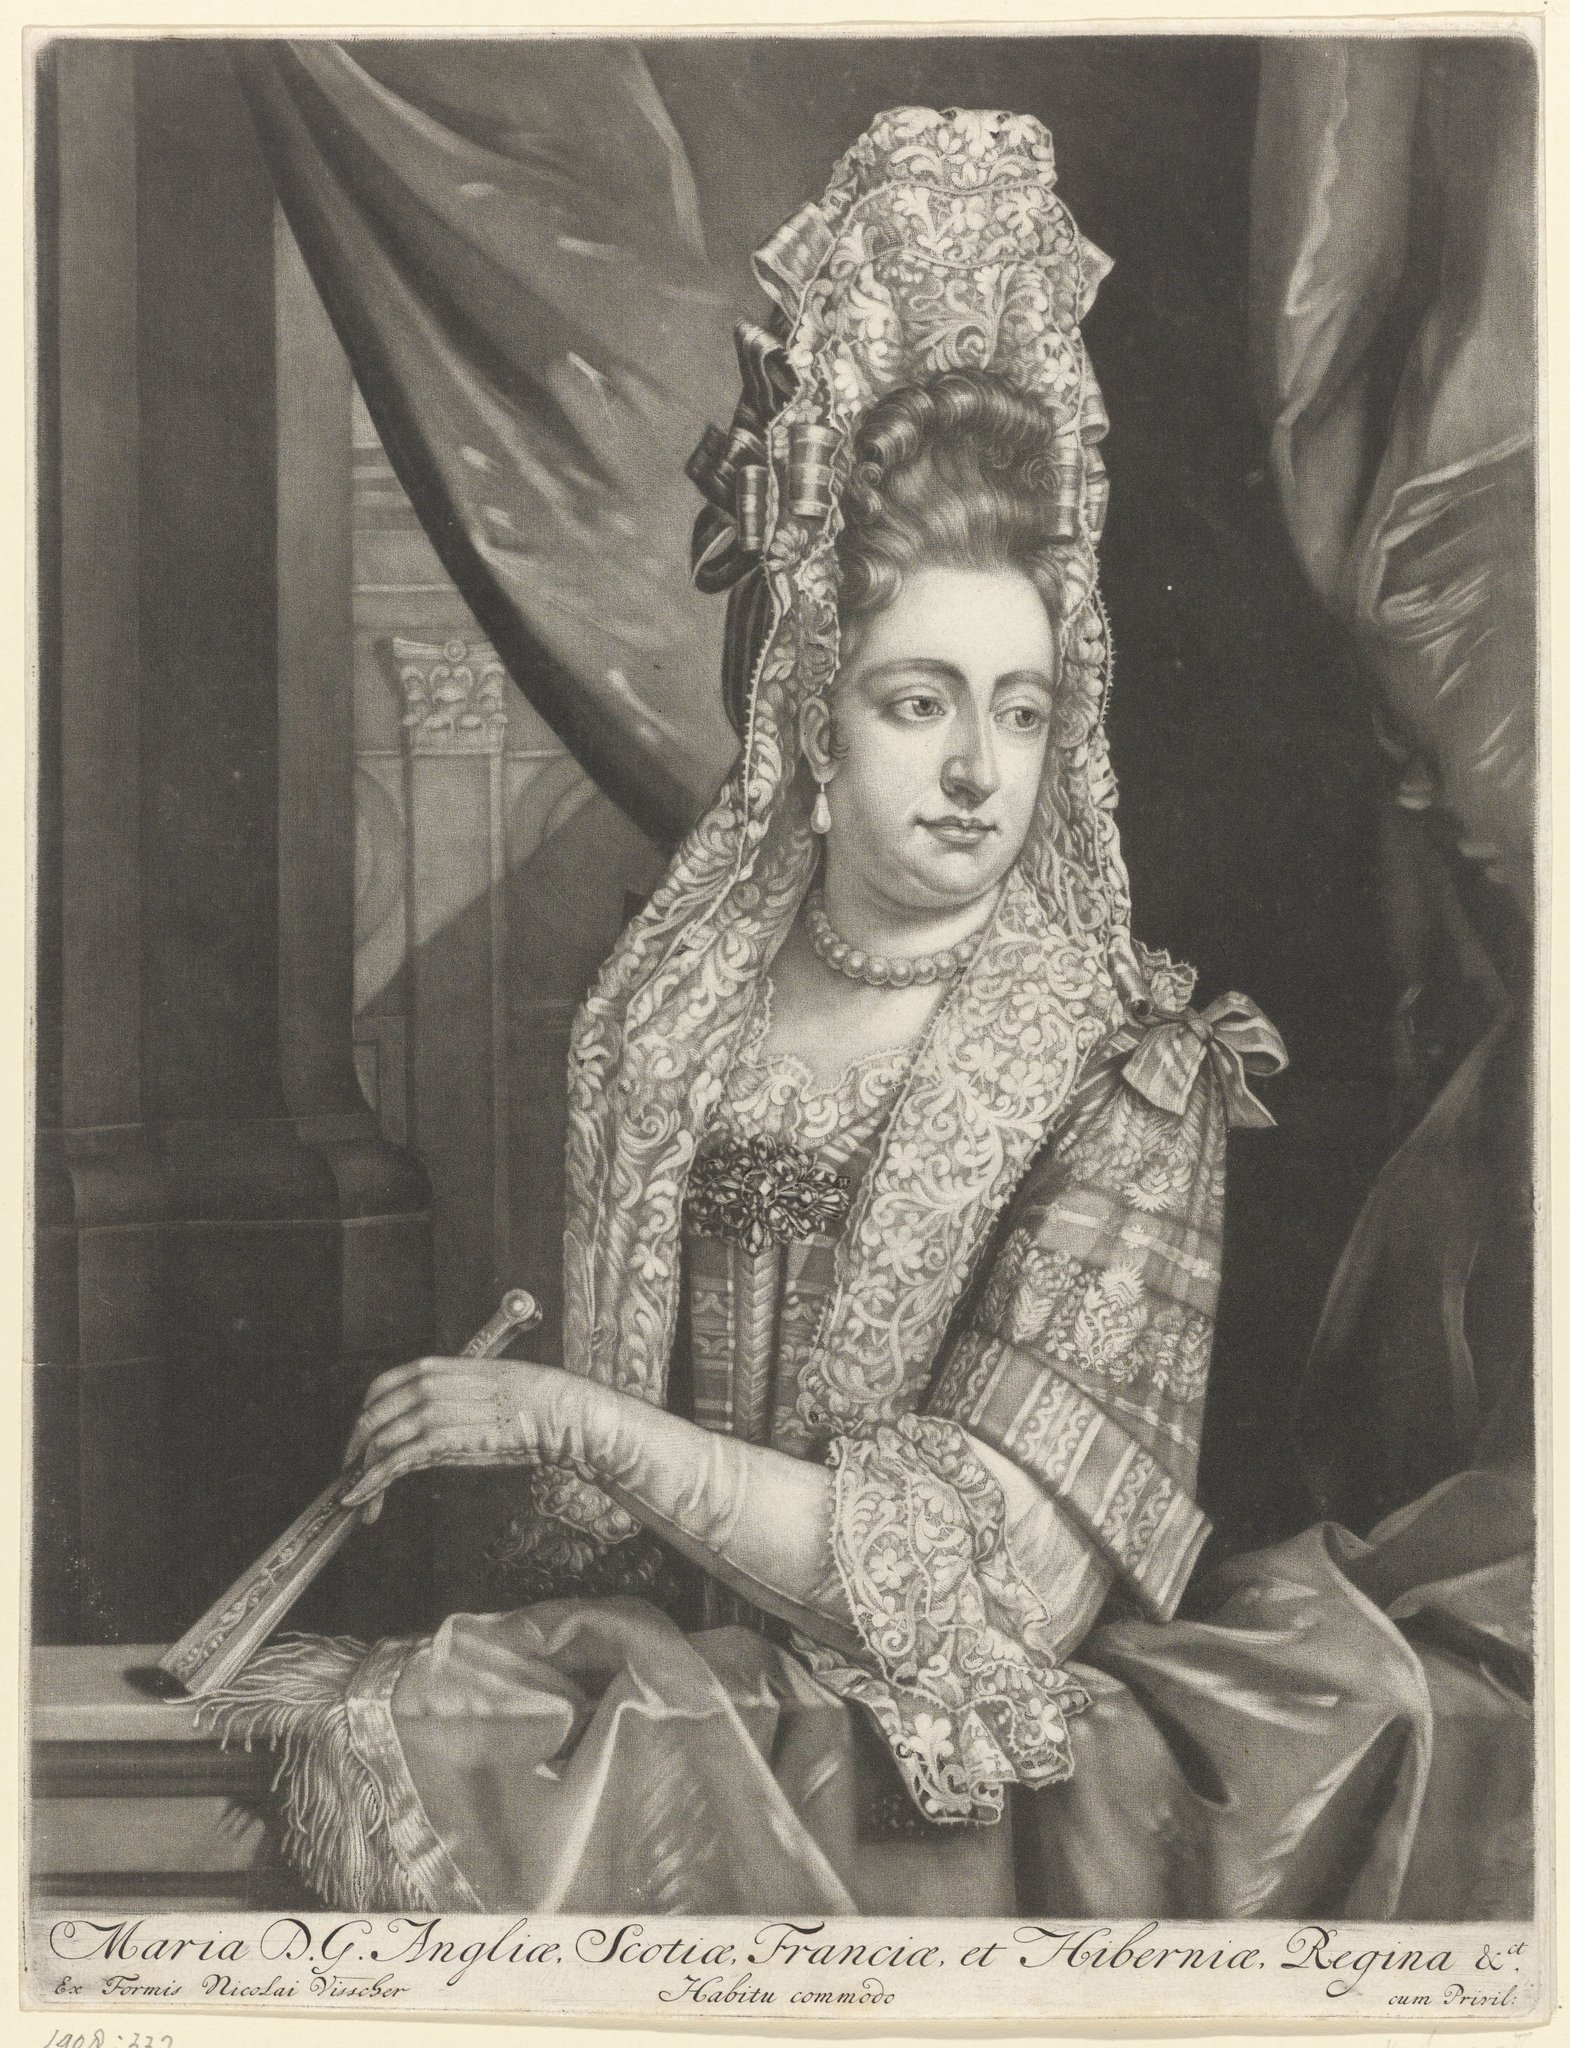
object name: print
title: Portret van Maria II Stuart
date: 1688-1709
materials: paper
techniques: mezzotint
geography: amsterdam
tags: london, maria ii stuart (koningin van engeland, schotland en ierland)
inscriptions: collector's mark: Lugt 2228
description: Portret van Maria II. In haar linkerhand een waaier. In de ondermarge haar naam en titels.